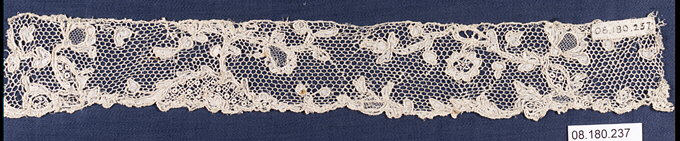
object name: fragment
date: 1701-1800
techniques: lace